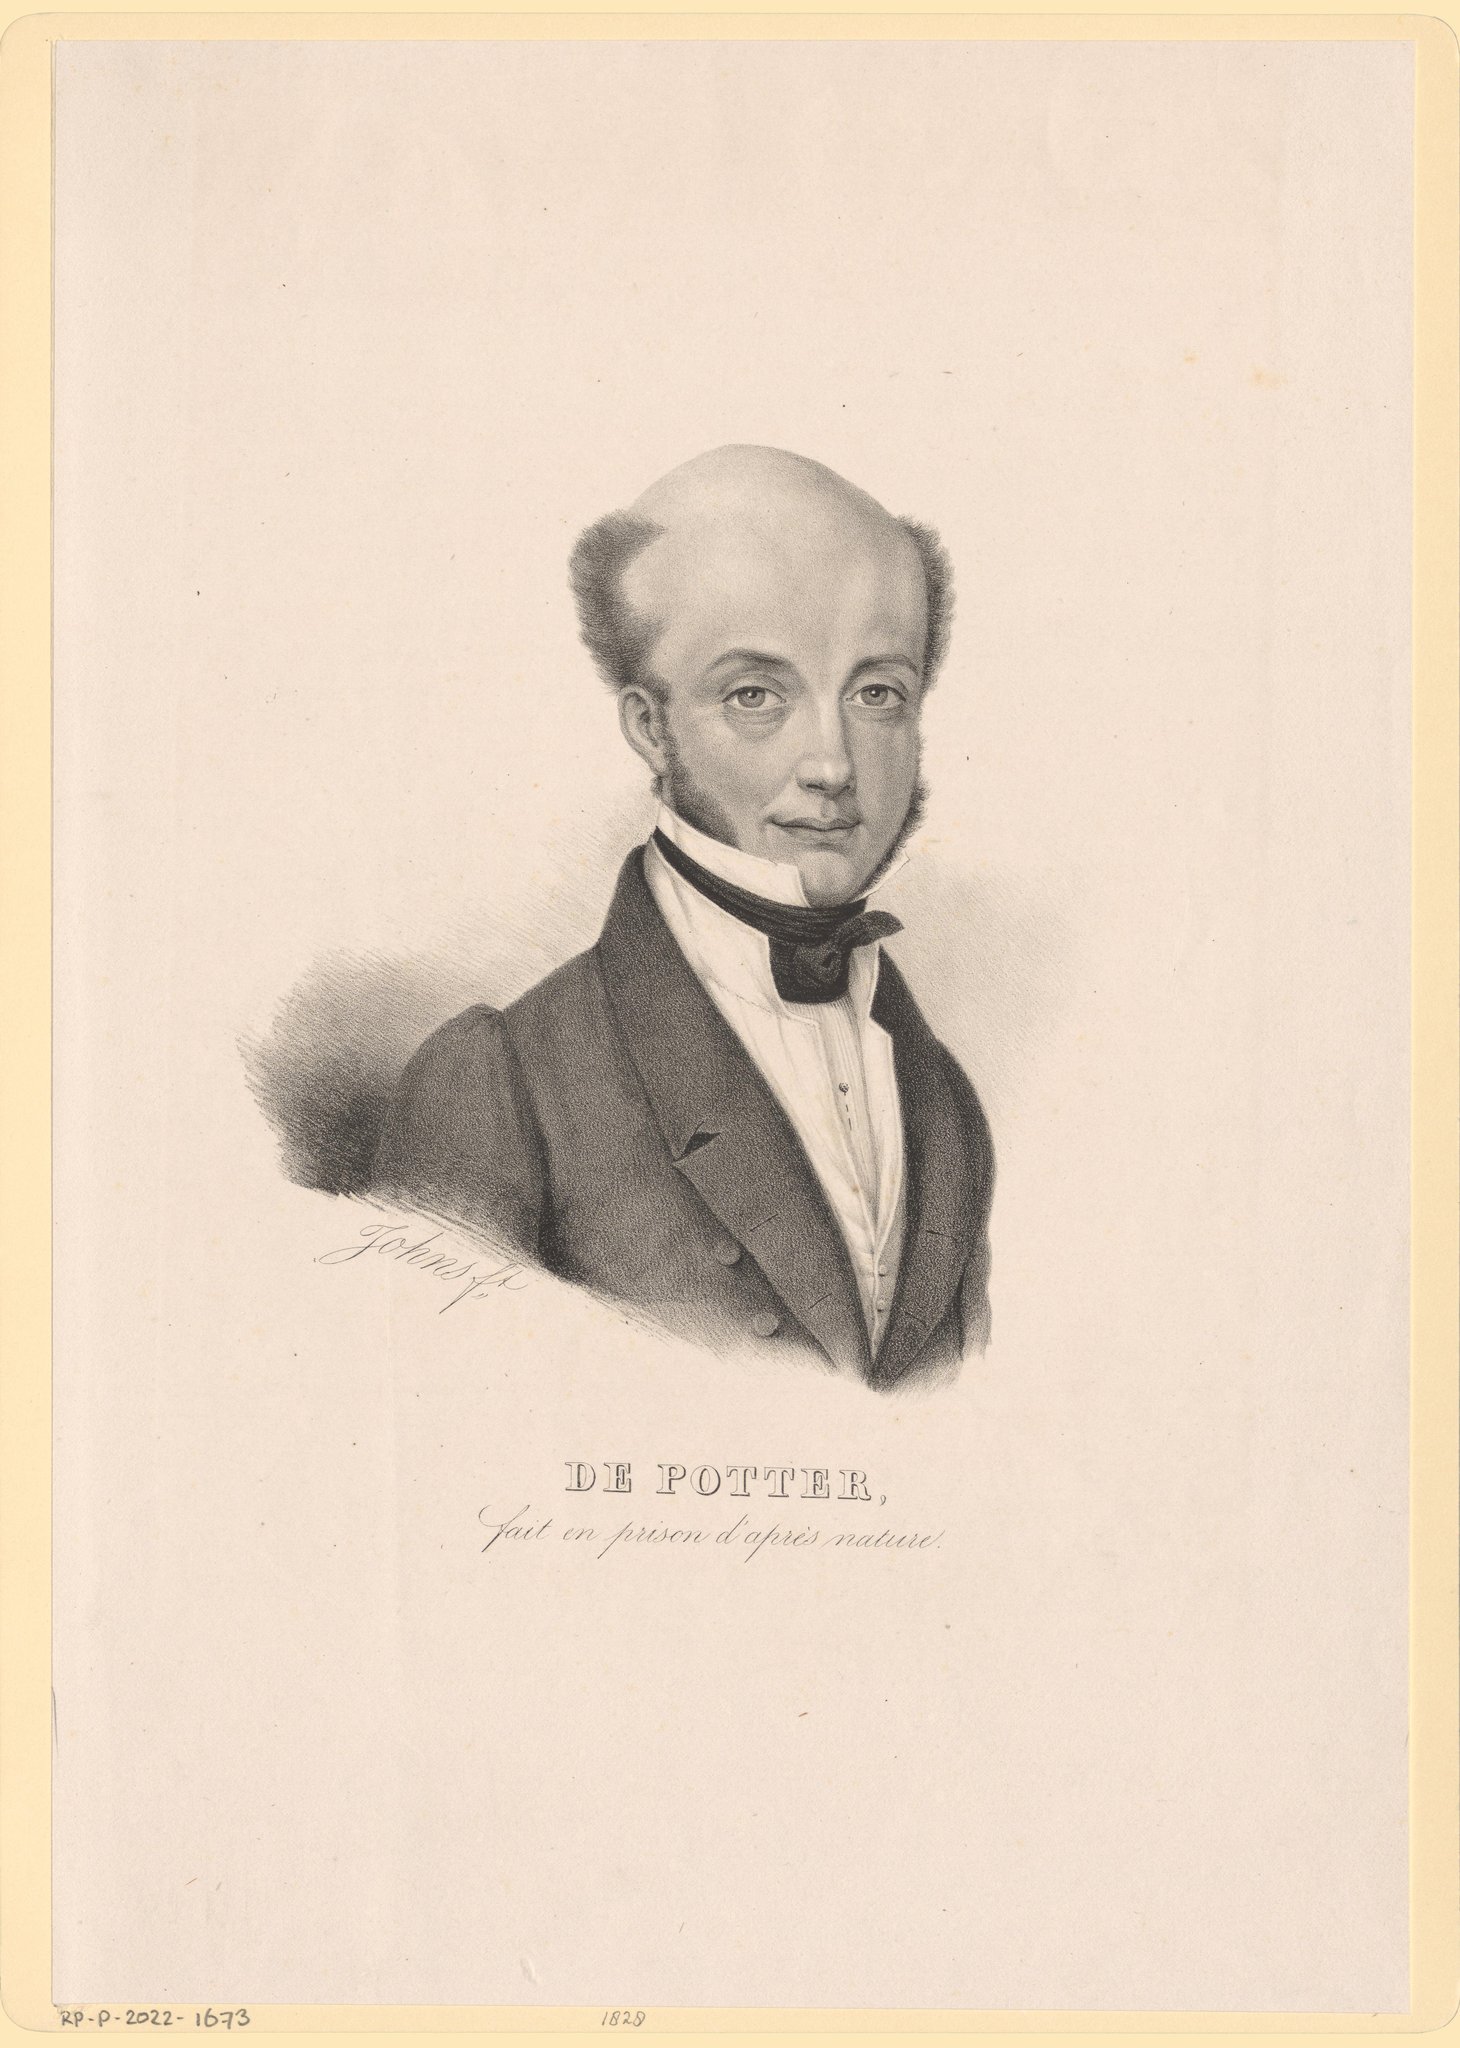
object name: print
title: De Potter, fait en prison d'après nature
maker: h. johns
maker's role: print maker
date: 1828-1830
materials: paper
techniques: lithograph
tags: bruges, politician, prison, jail, journalist, reporter, historical persons, politician, e.g. party leader